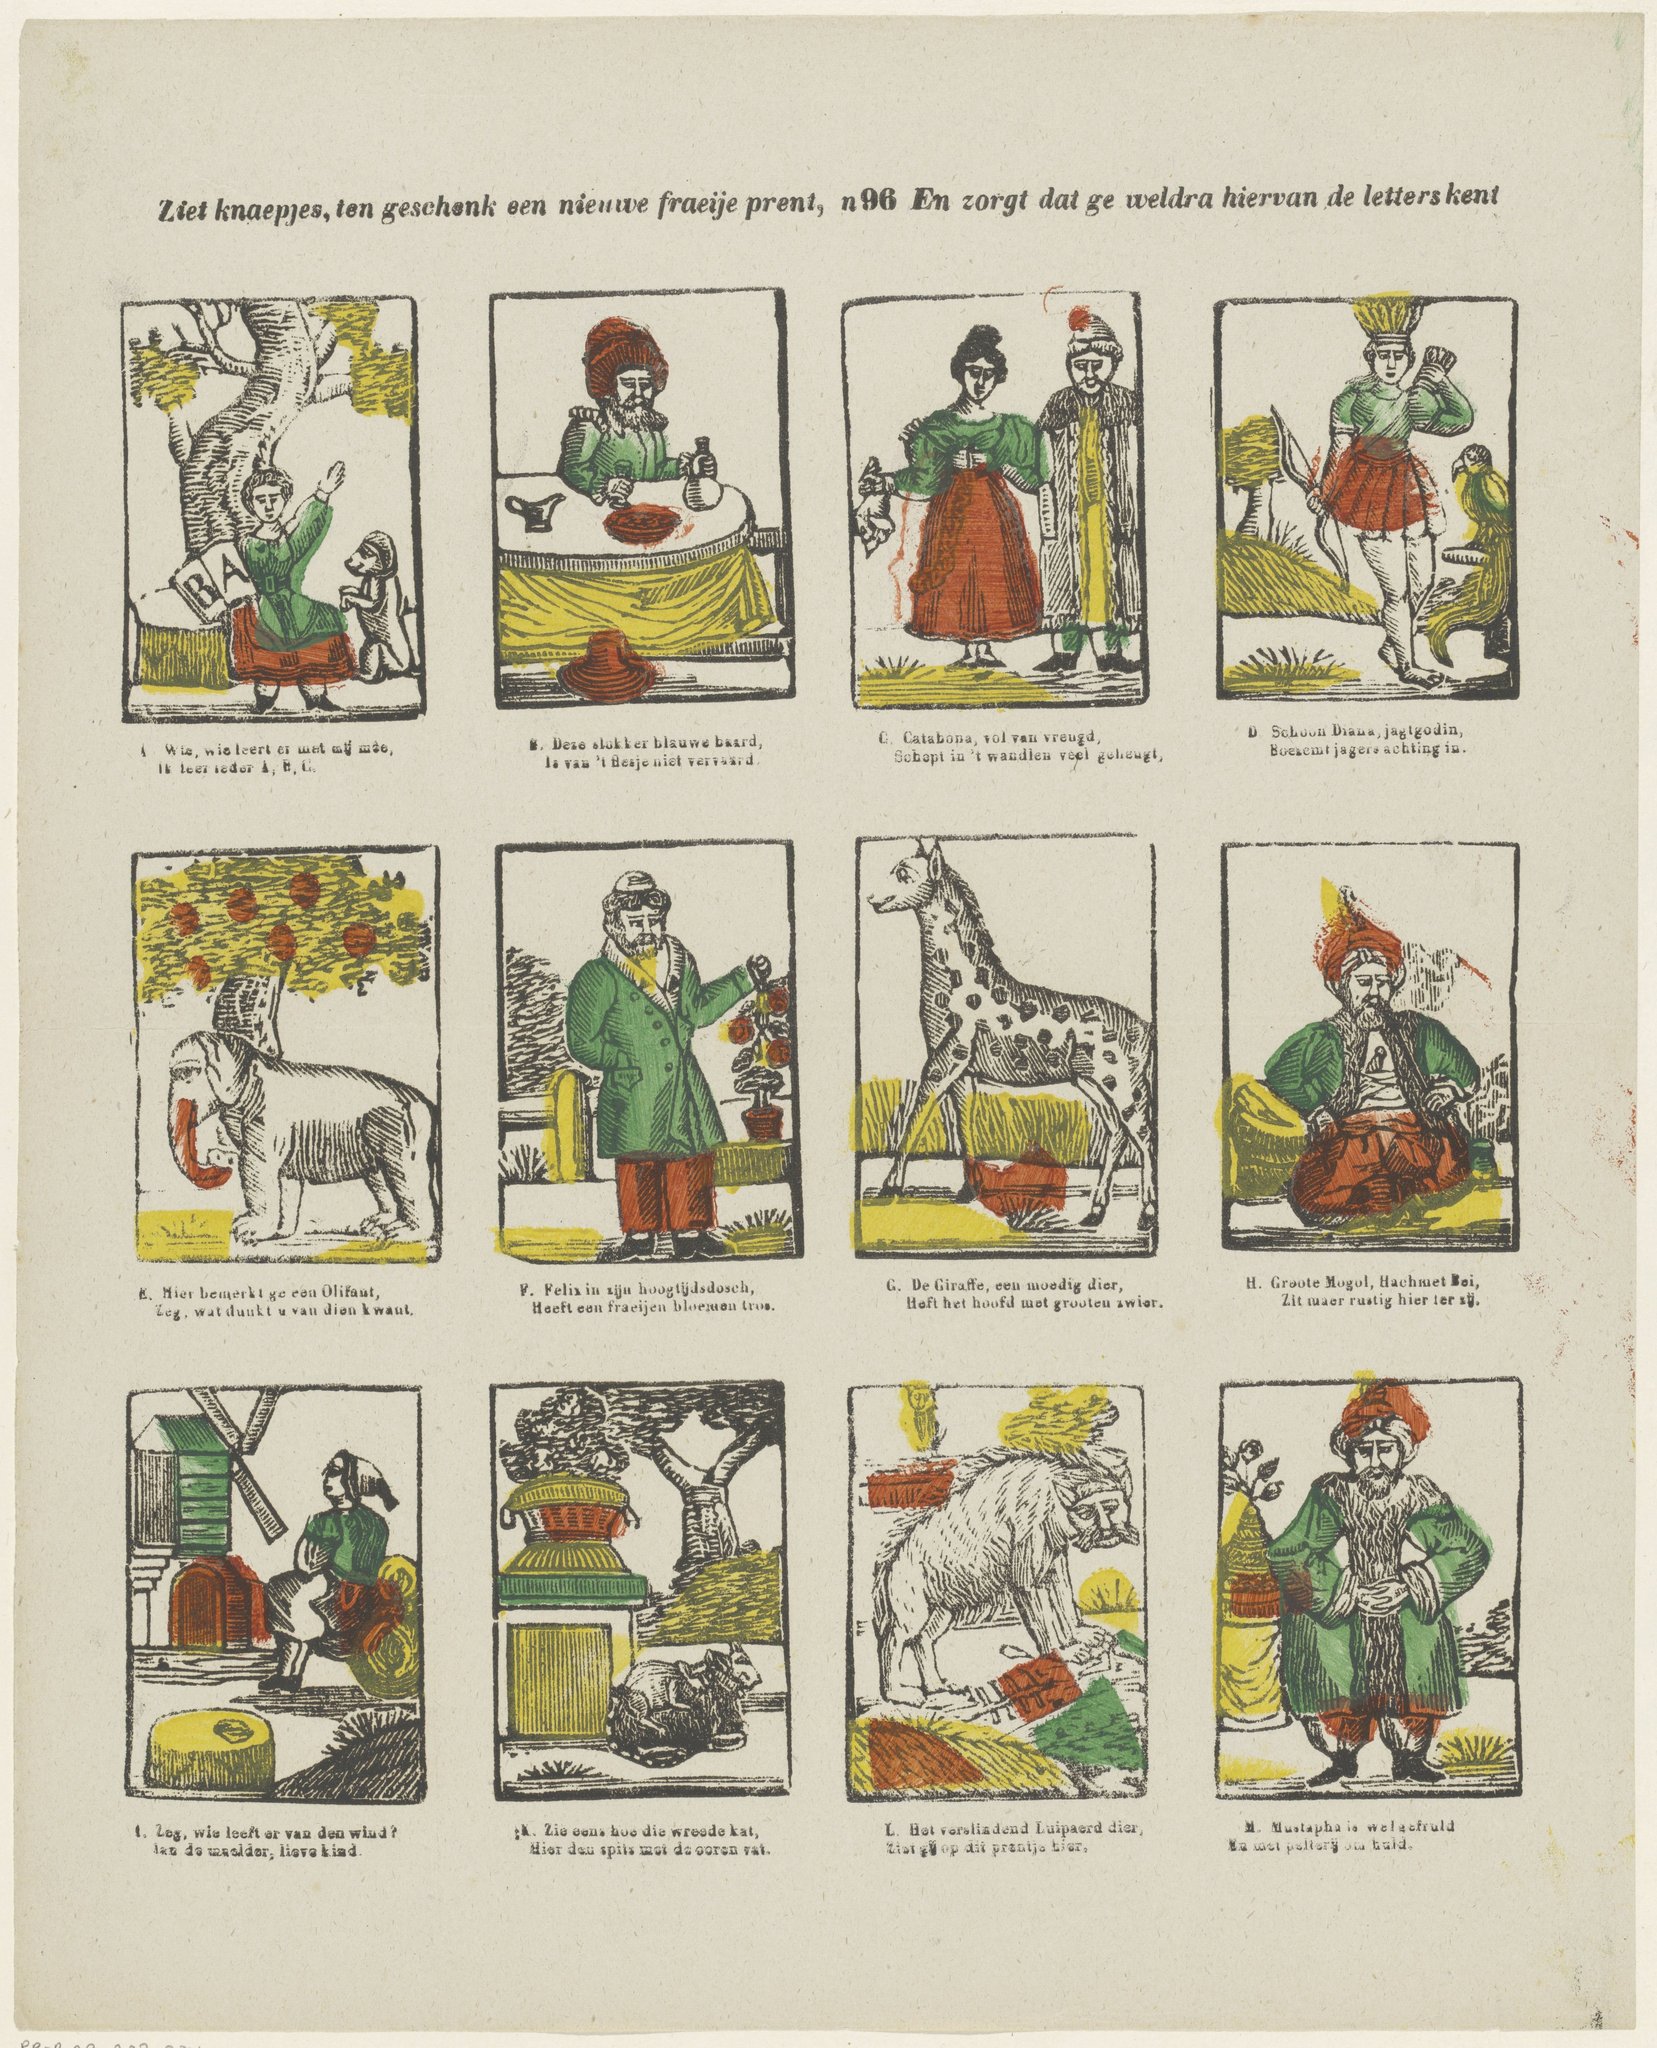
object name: print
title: Ziet knaepjes, ten geschenk een nieuwe fraeije prent, / En zorgt dat ge weldra hiervan de letters kent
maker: Anonymous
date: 1833-1900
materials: paper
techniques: colour, letterpress printing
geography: netherlands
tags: animals, letters, alphabet, script, characters (human types), gods ~ classical mythology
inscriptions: collector's mark: Lugt 2760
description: Blad met 12 voorstellingen van de letters van het alfabet (A-M) geïllustreerd met goden, dieren en figuren waarvan de woorden met de betreffende letter beginnen. Onder elke afbeelding een tweeregelig vers. Genummerd midden boven: n 96.